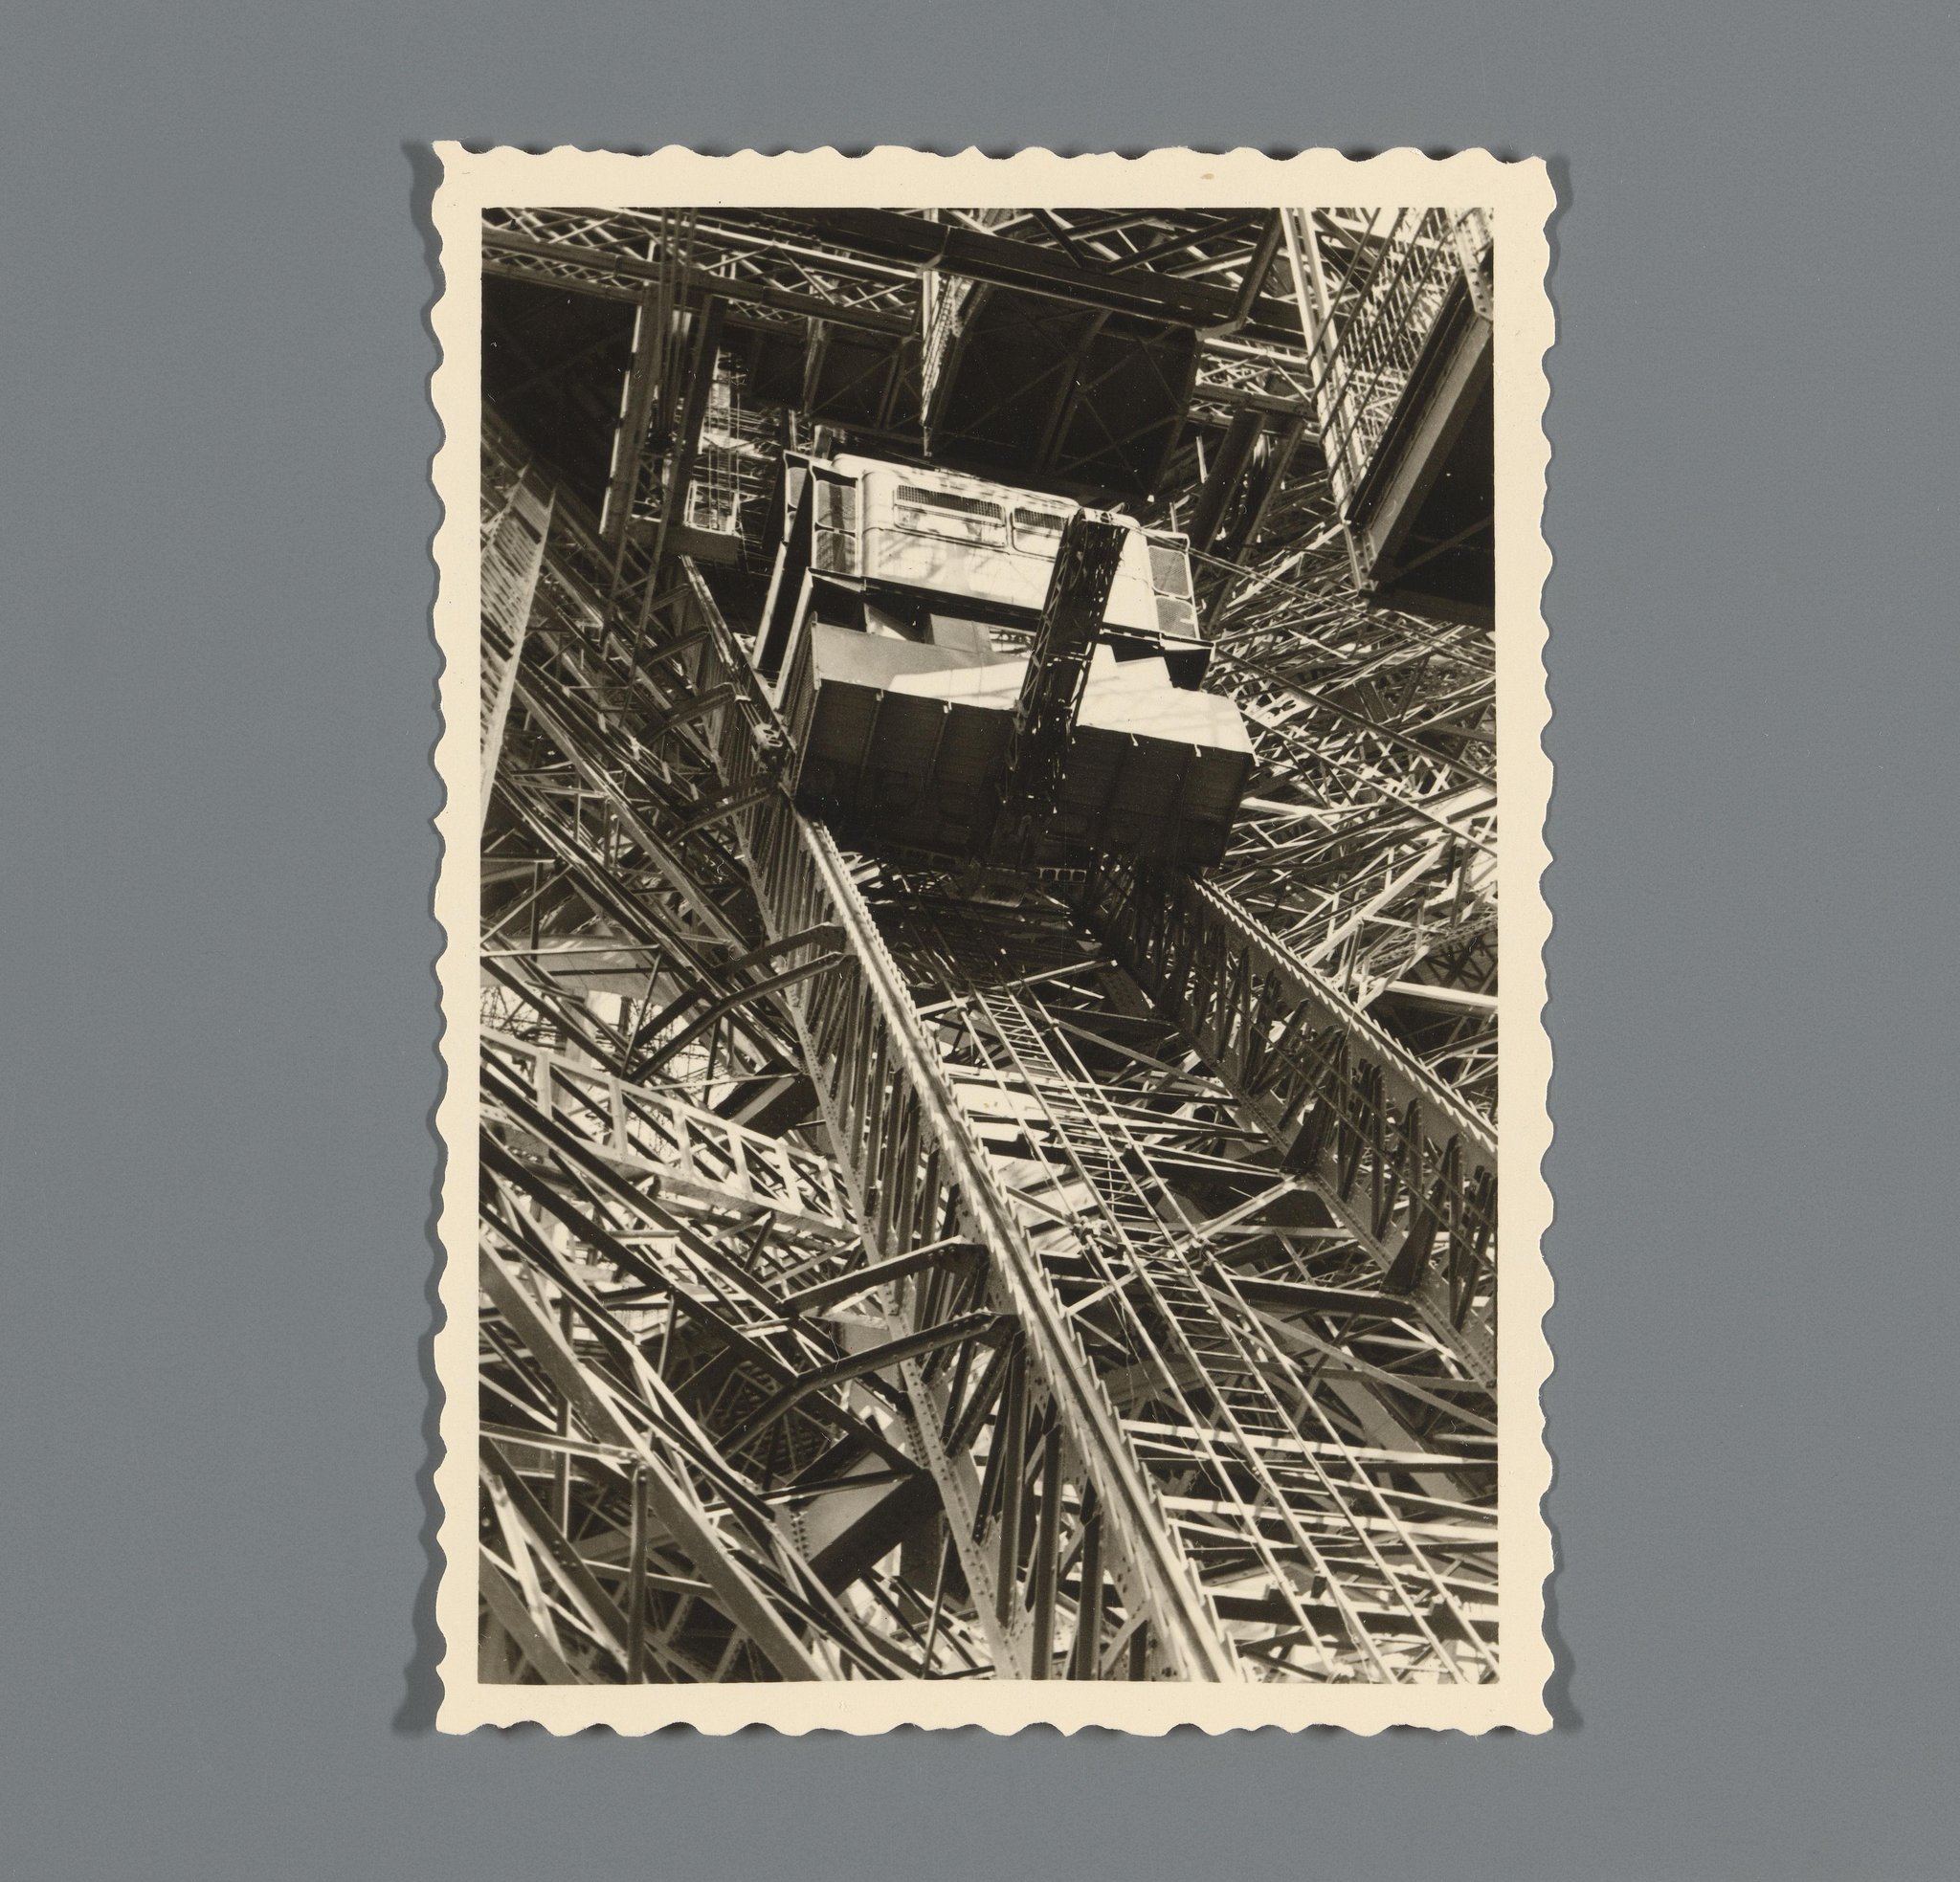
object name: photograph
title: De Eiffeltoren van onderaf gezien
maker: Anonymous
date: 1920-1940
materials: photographic support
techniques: gelatin silver print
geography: paris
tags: eiffel tower